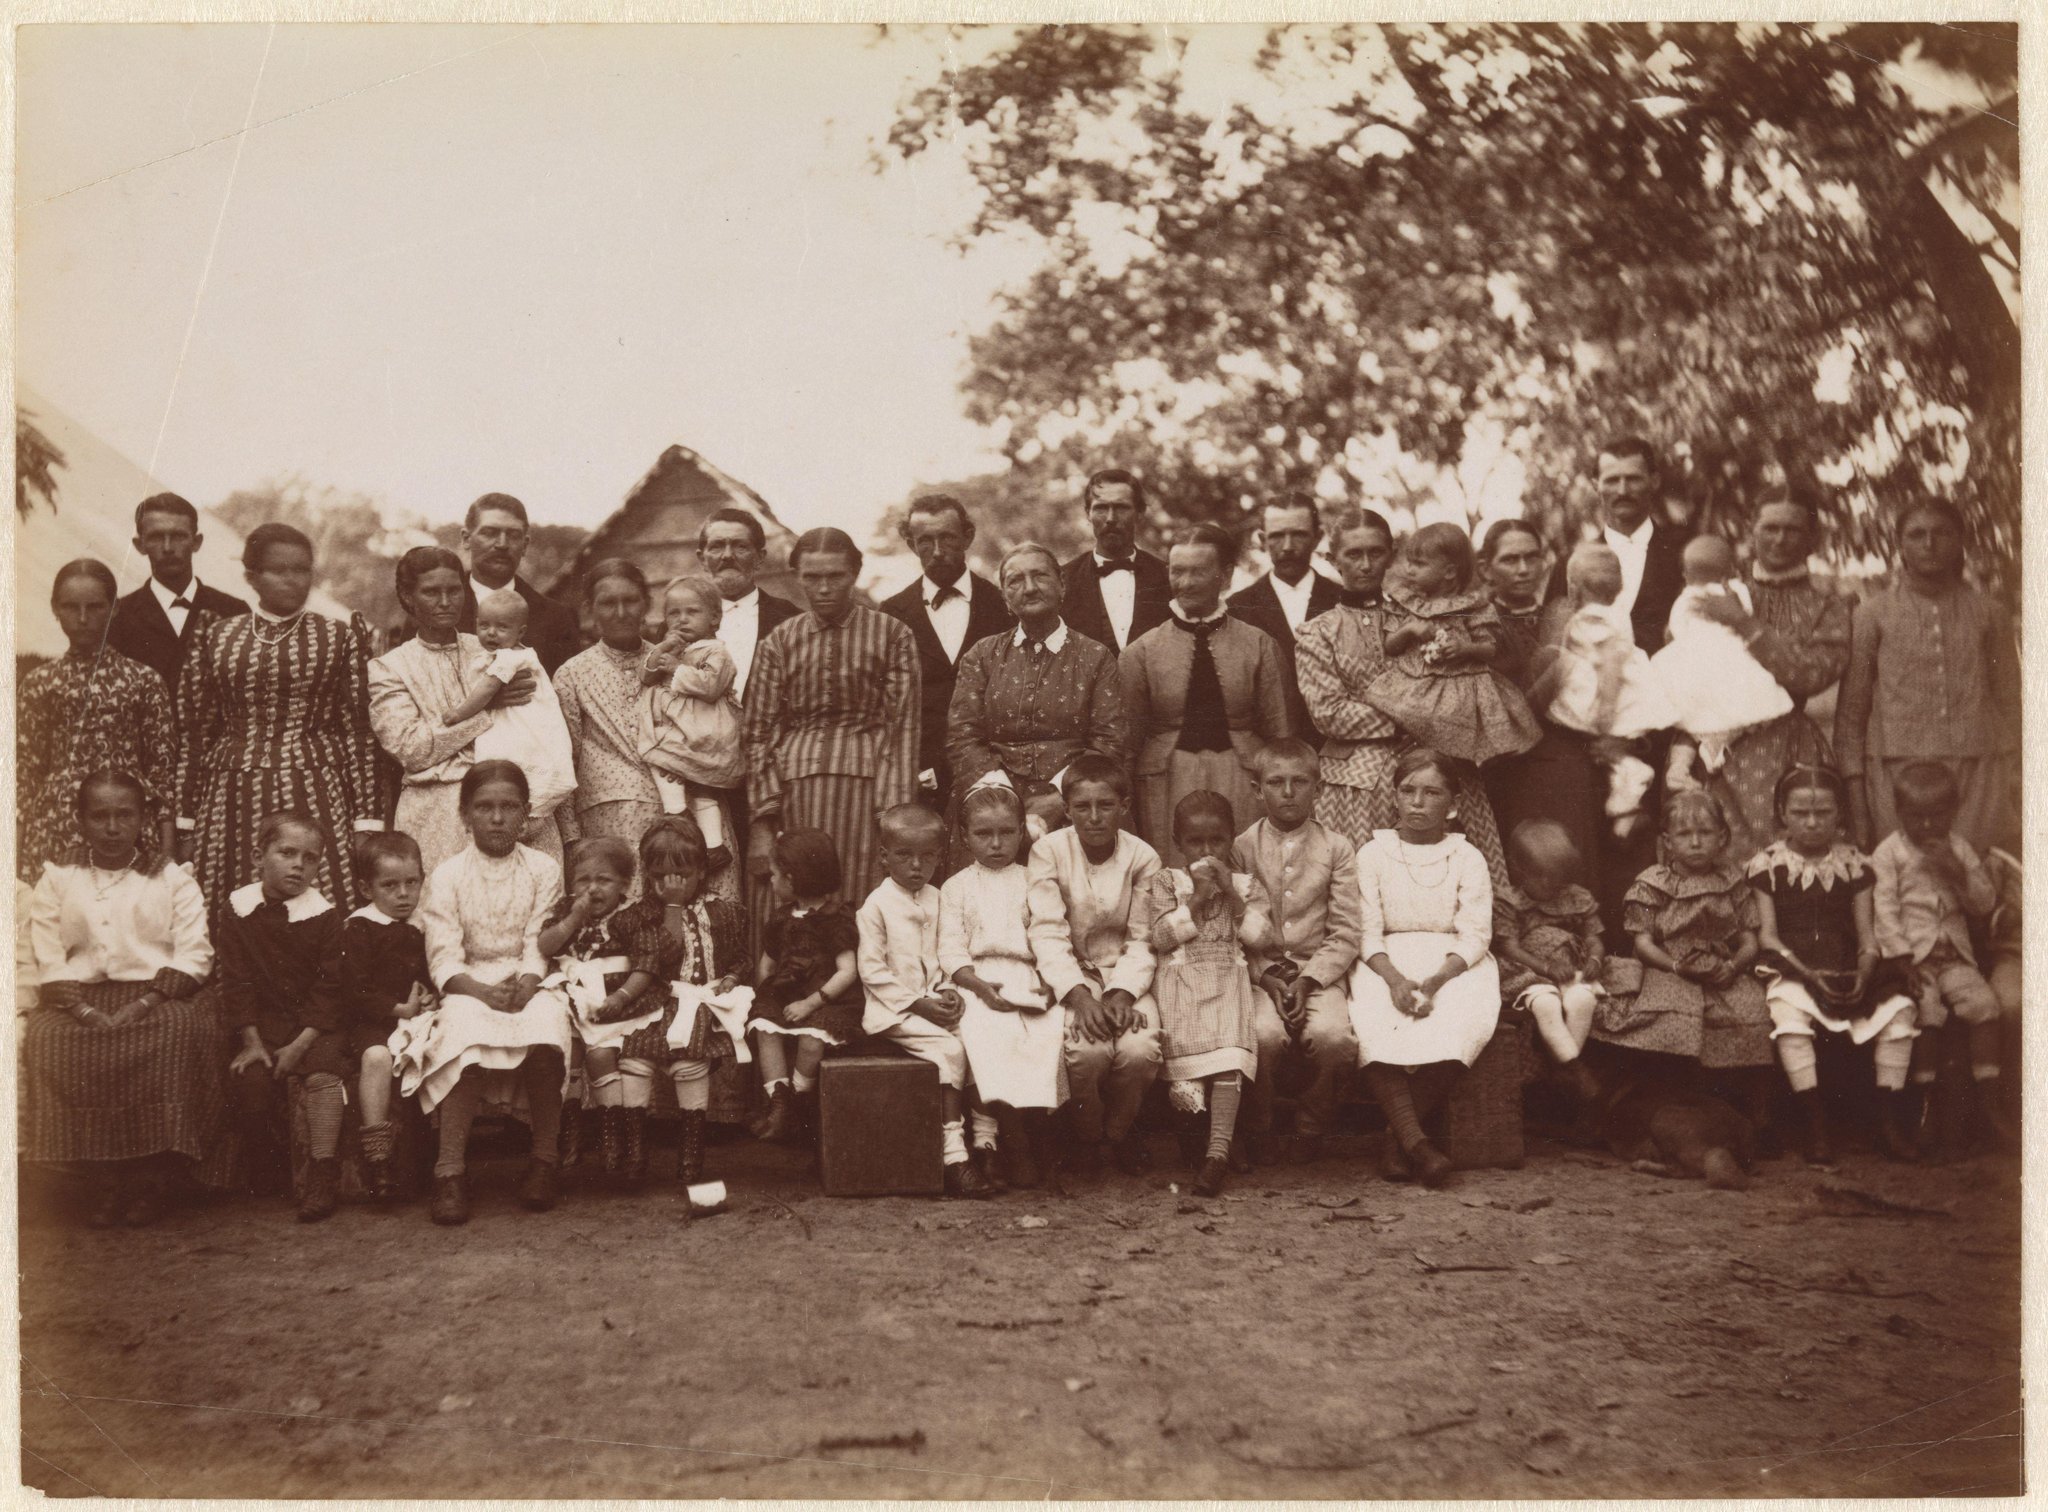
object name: photograph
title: Boeren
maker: julius muller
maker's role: official, politician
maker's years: 1846-1902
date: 1898-1902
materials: photographic support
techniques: albumen print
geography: suriname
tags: suriname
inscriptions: inscription: ‘Boeren’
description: De familie Taminga (ook wel geschreven als Tammenga of Tamminga) behoorde tot de eerste lichting boerenkolonisten die in 1845 uit Nederland naar Suriname kwamen. Muller heeft hen waarschijnlijk gefotografeerd bij hun huis aan de Gemeene Landsweg bij Paramaribo. Samen met zijn vriend dr. C. Hoekstra verdiepte Muller zich in de geschiedenis van de boerenkolonisatie in 1845 aan de Saramaccarivier. Hij schonk driehonderd foto’s aan het Koloniaal Museum in Haarlem voor een rondreizende tentoonstelling die een nieuwe wervingsactie van boeren uit Nederland moest betekenen.